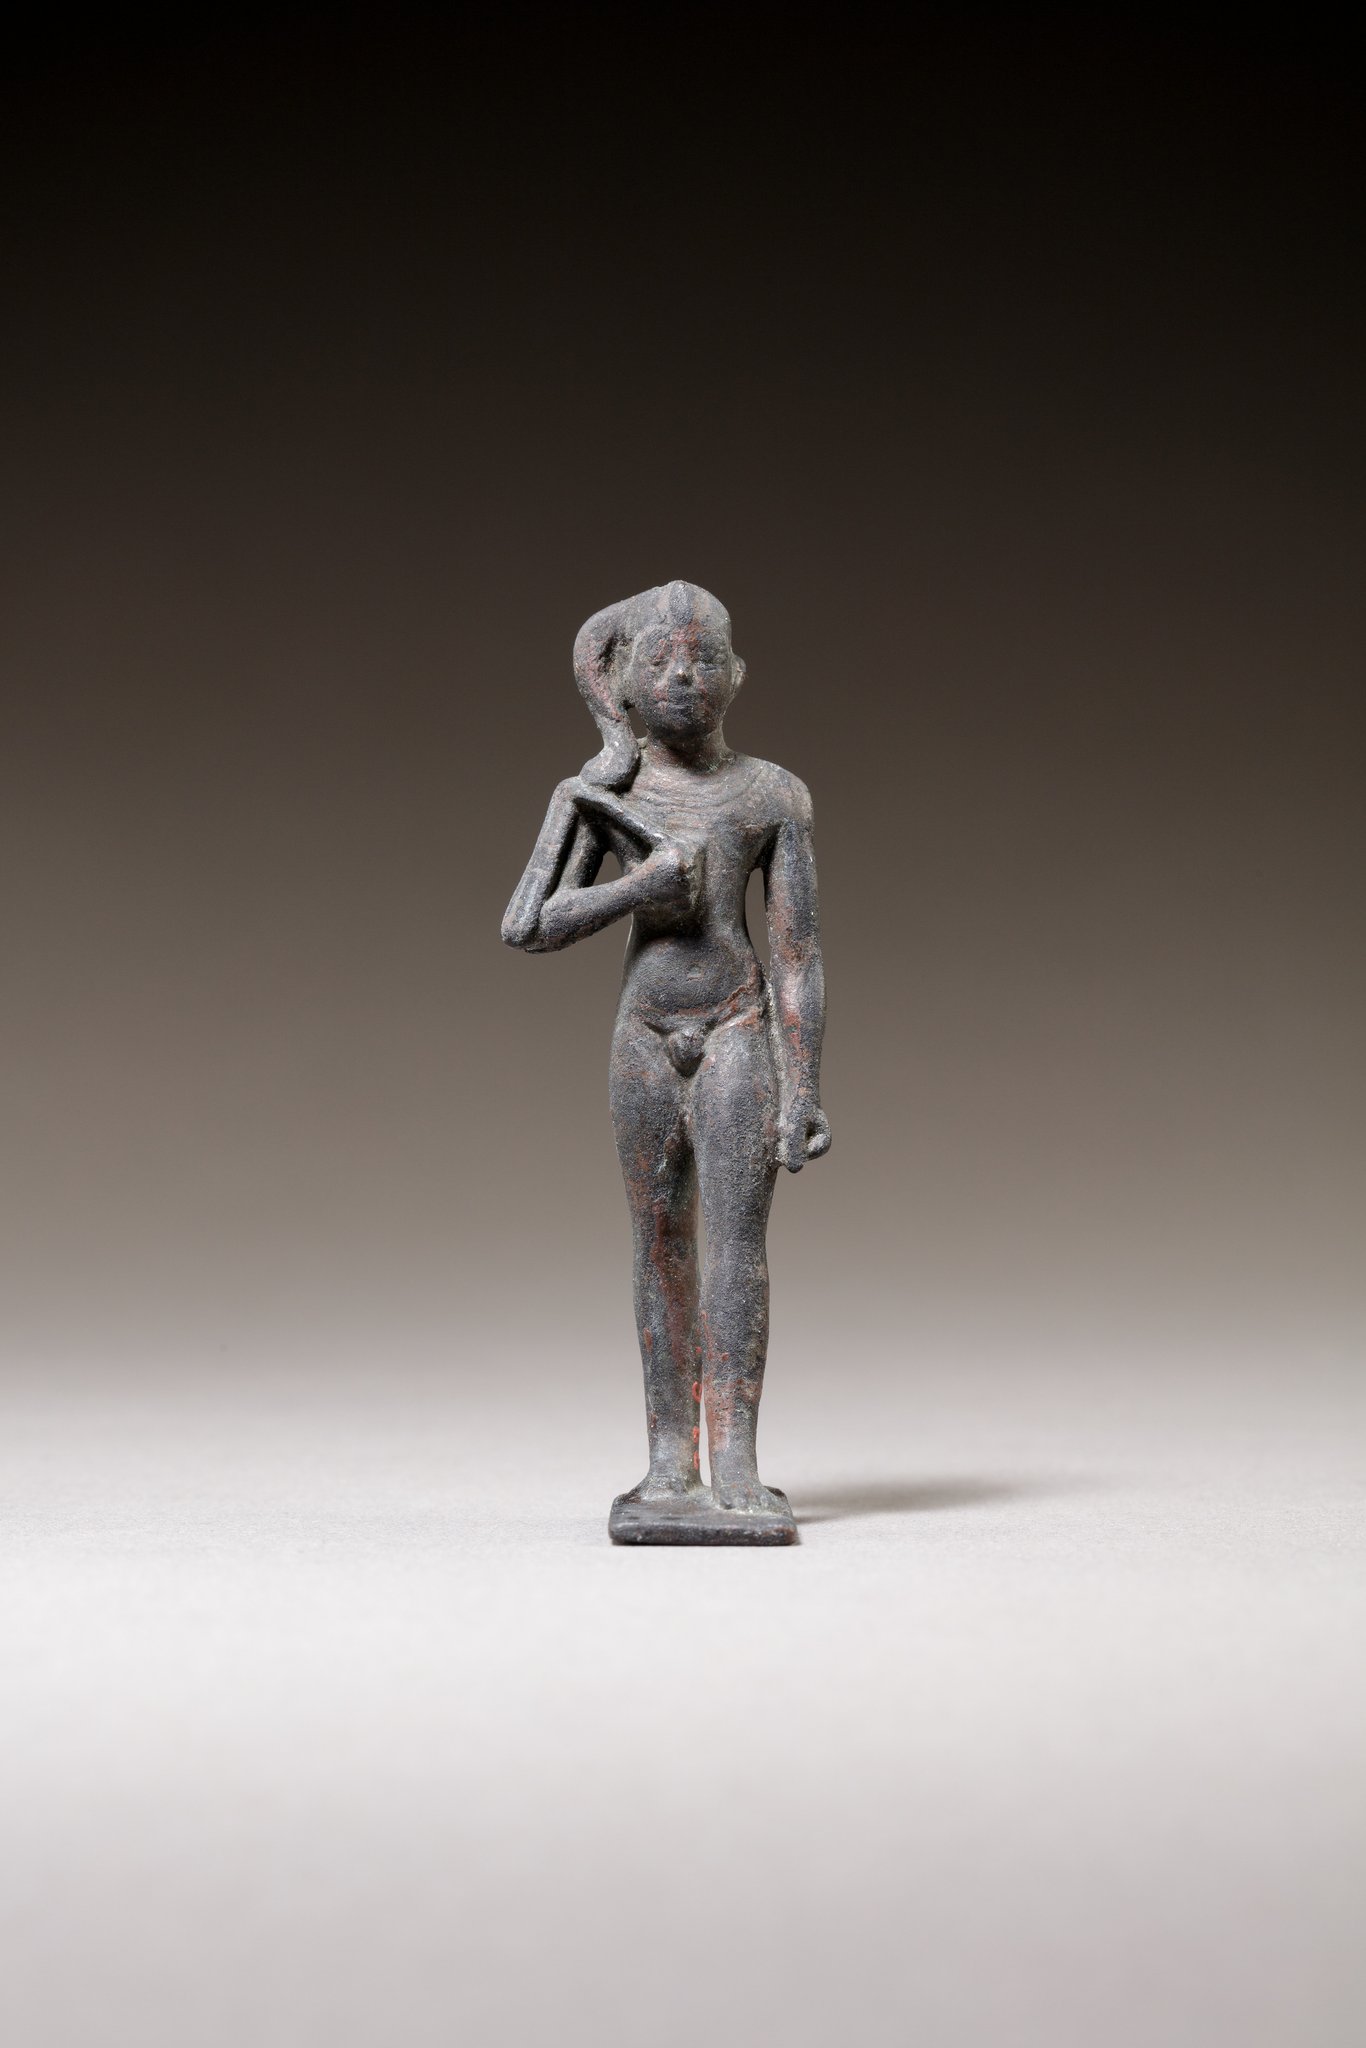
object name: statuette, child god, flail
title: Child god standing and holding a flail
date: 664-630 BCE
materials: alloy, bronze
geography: egypt